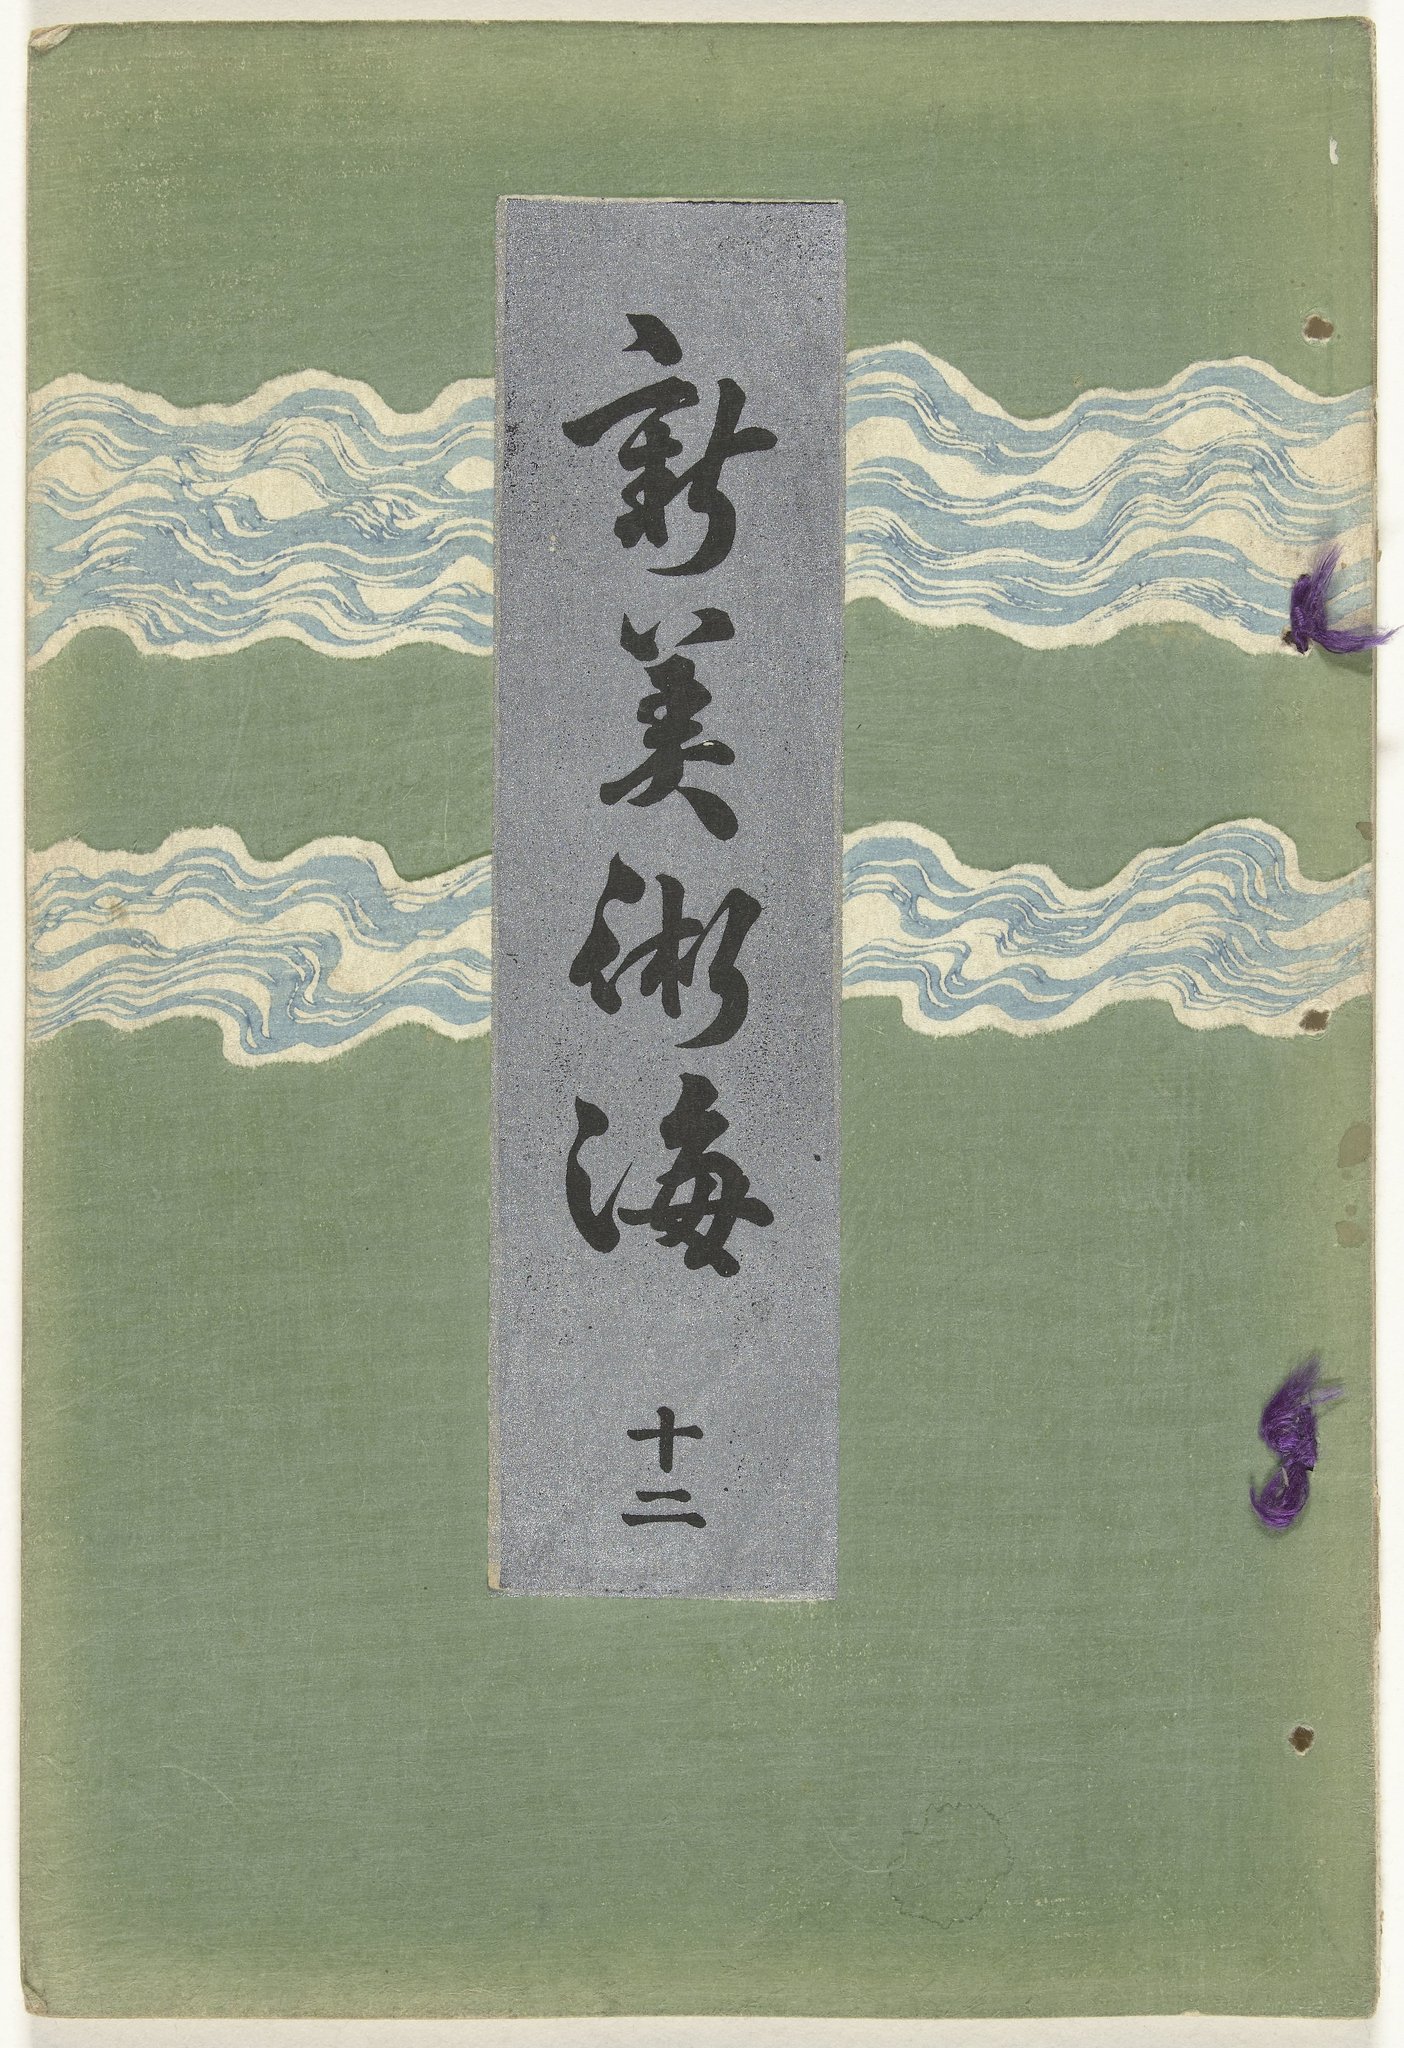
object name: book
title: Shin bijutsukai - juni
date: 1903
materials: gold powder, paper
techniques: woodcut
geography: kyoto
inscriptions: date